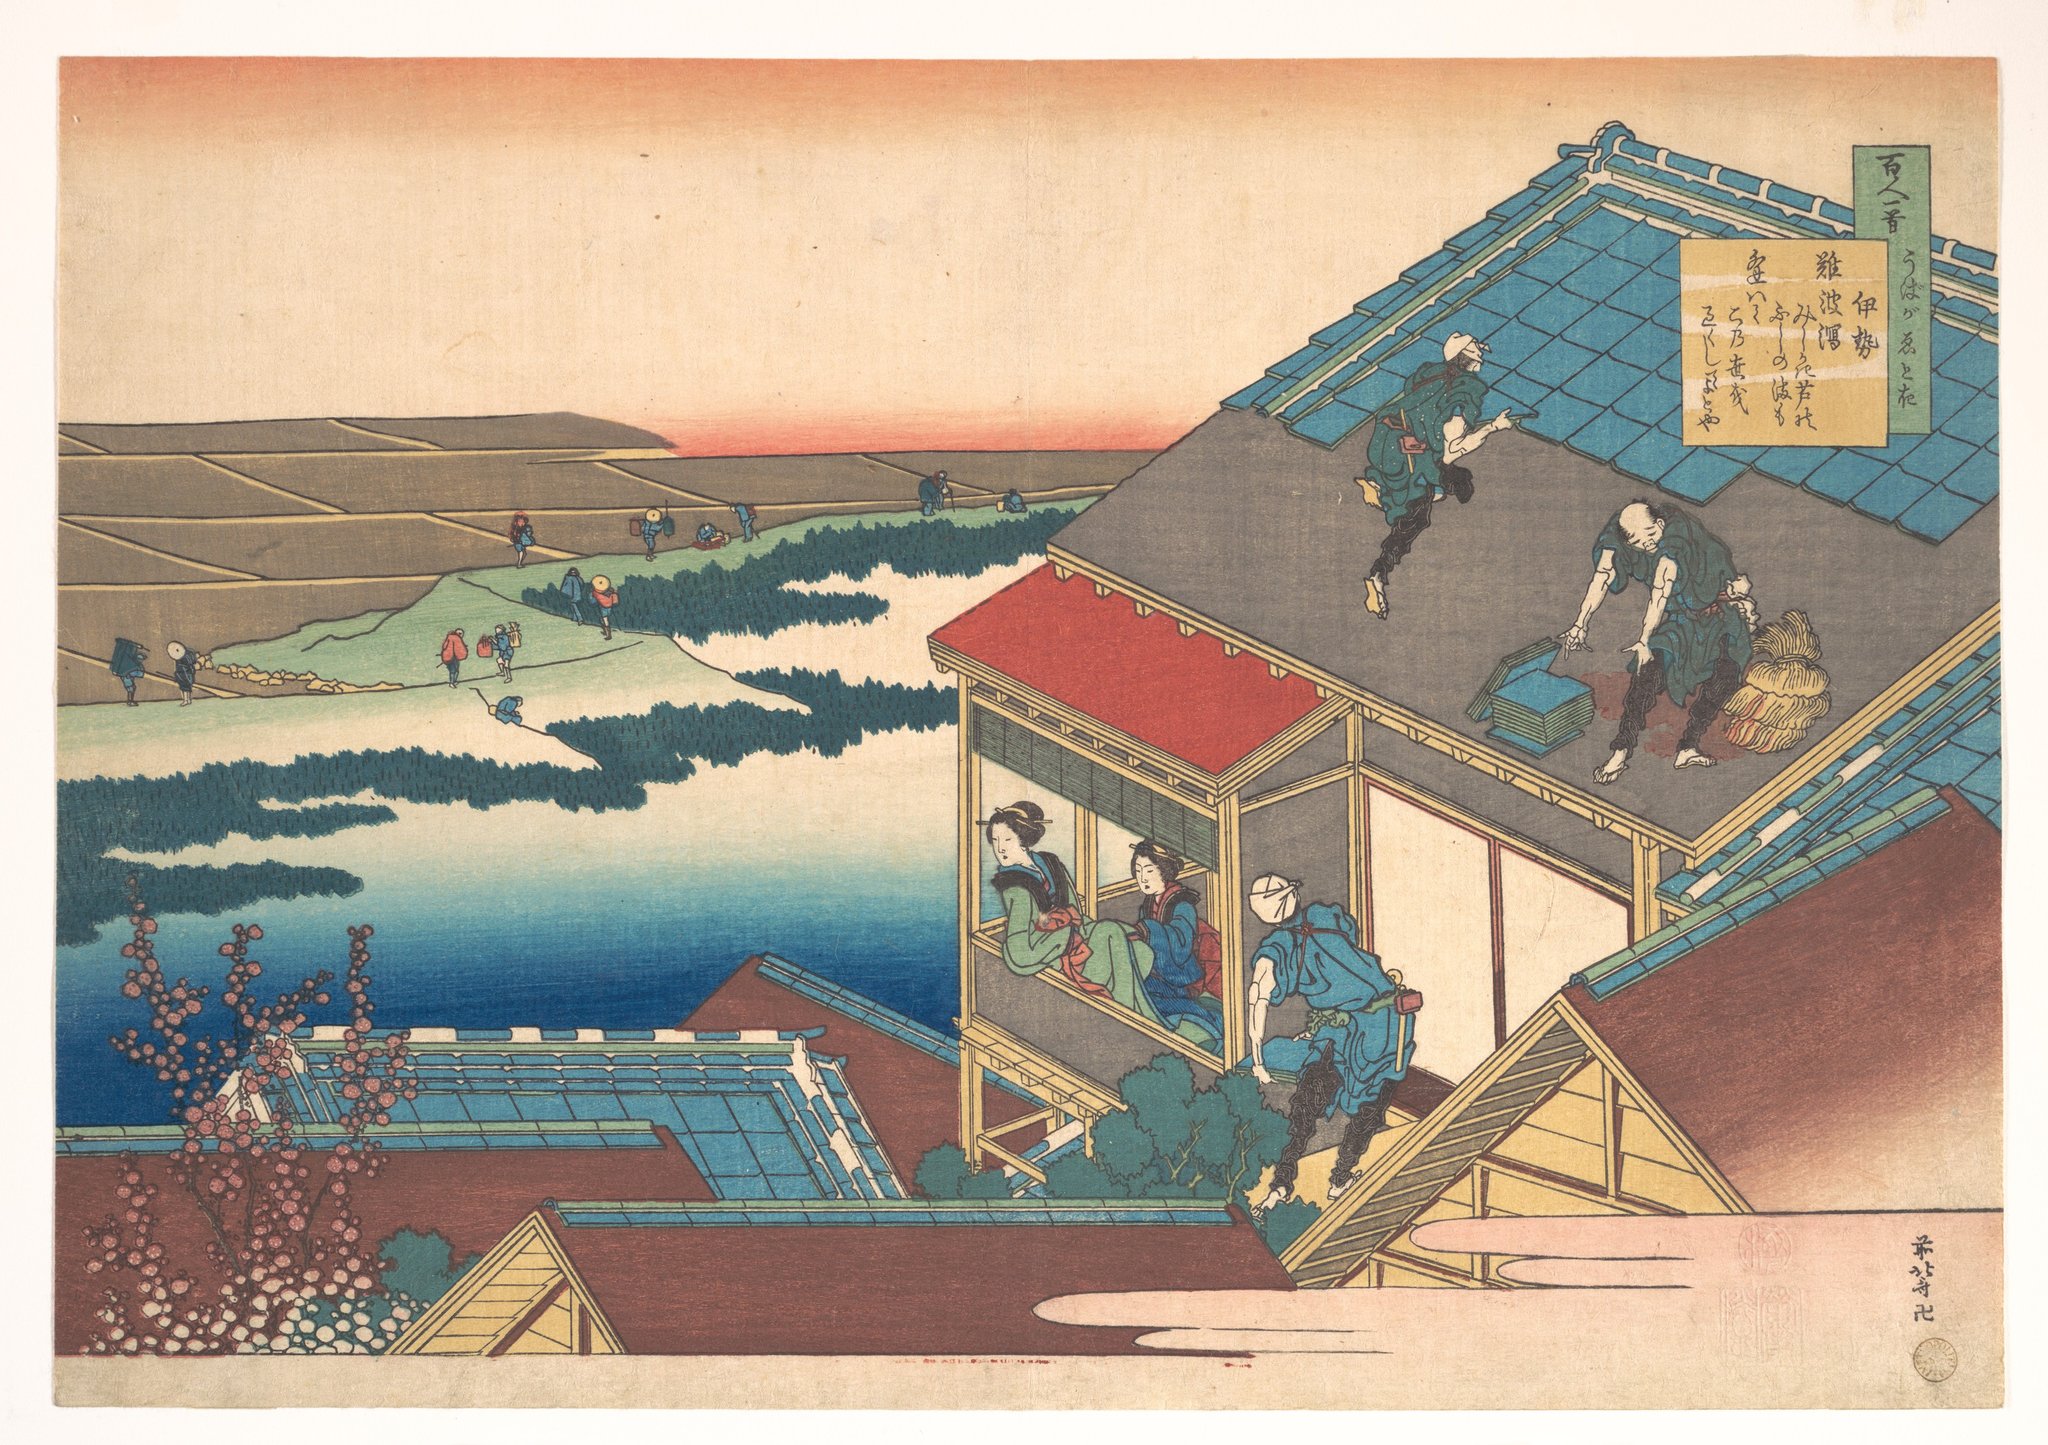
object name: woodblock print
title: Poem by Ise, from the series One Hundred Poems Explained by the Nurse (Hyakunin isshu uba ga etoki)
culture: japanese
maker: katsushika hokusai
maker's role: artist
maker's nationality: japanese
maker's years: 1760-1849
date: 1839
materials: ink, paper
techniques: woodblock print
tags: buildings,men,women,working